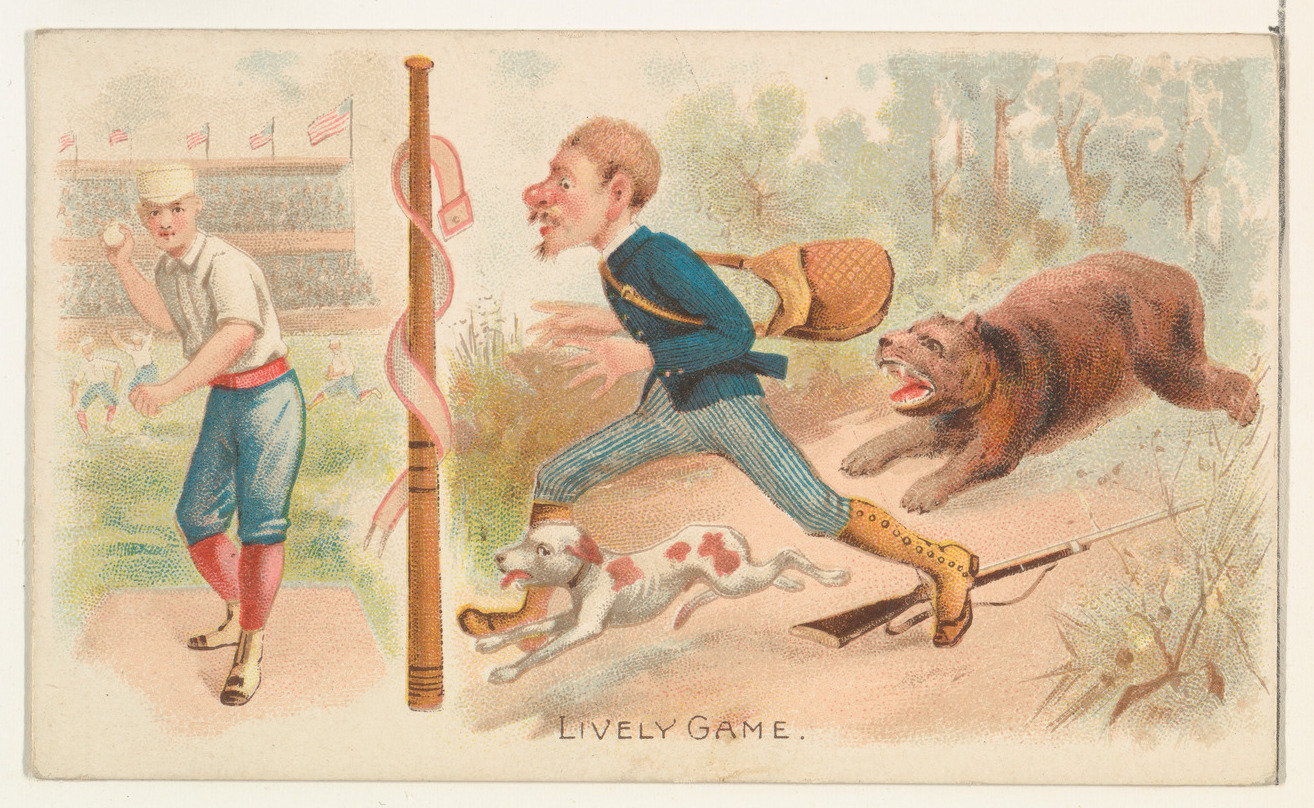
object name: print, baseball card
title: Lively Game, from the Talk of the Diamond set (N135) issued by Duke Sons & Co., a branch of the American Tobacco Company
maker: w. duke, sons & co.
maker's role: publisher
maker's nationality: american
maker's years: 1870-1920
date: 1888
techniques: color lithograph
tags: bears,men,sports,dogs,athletes